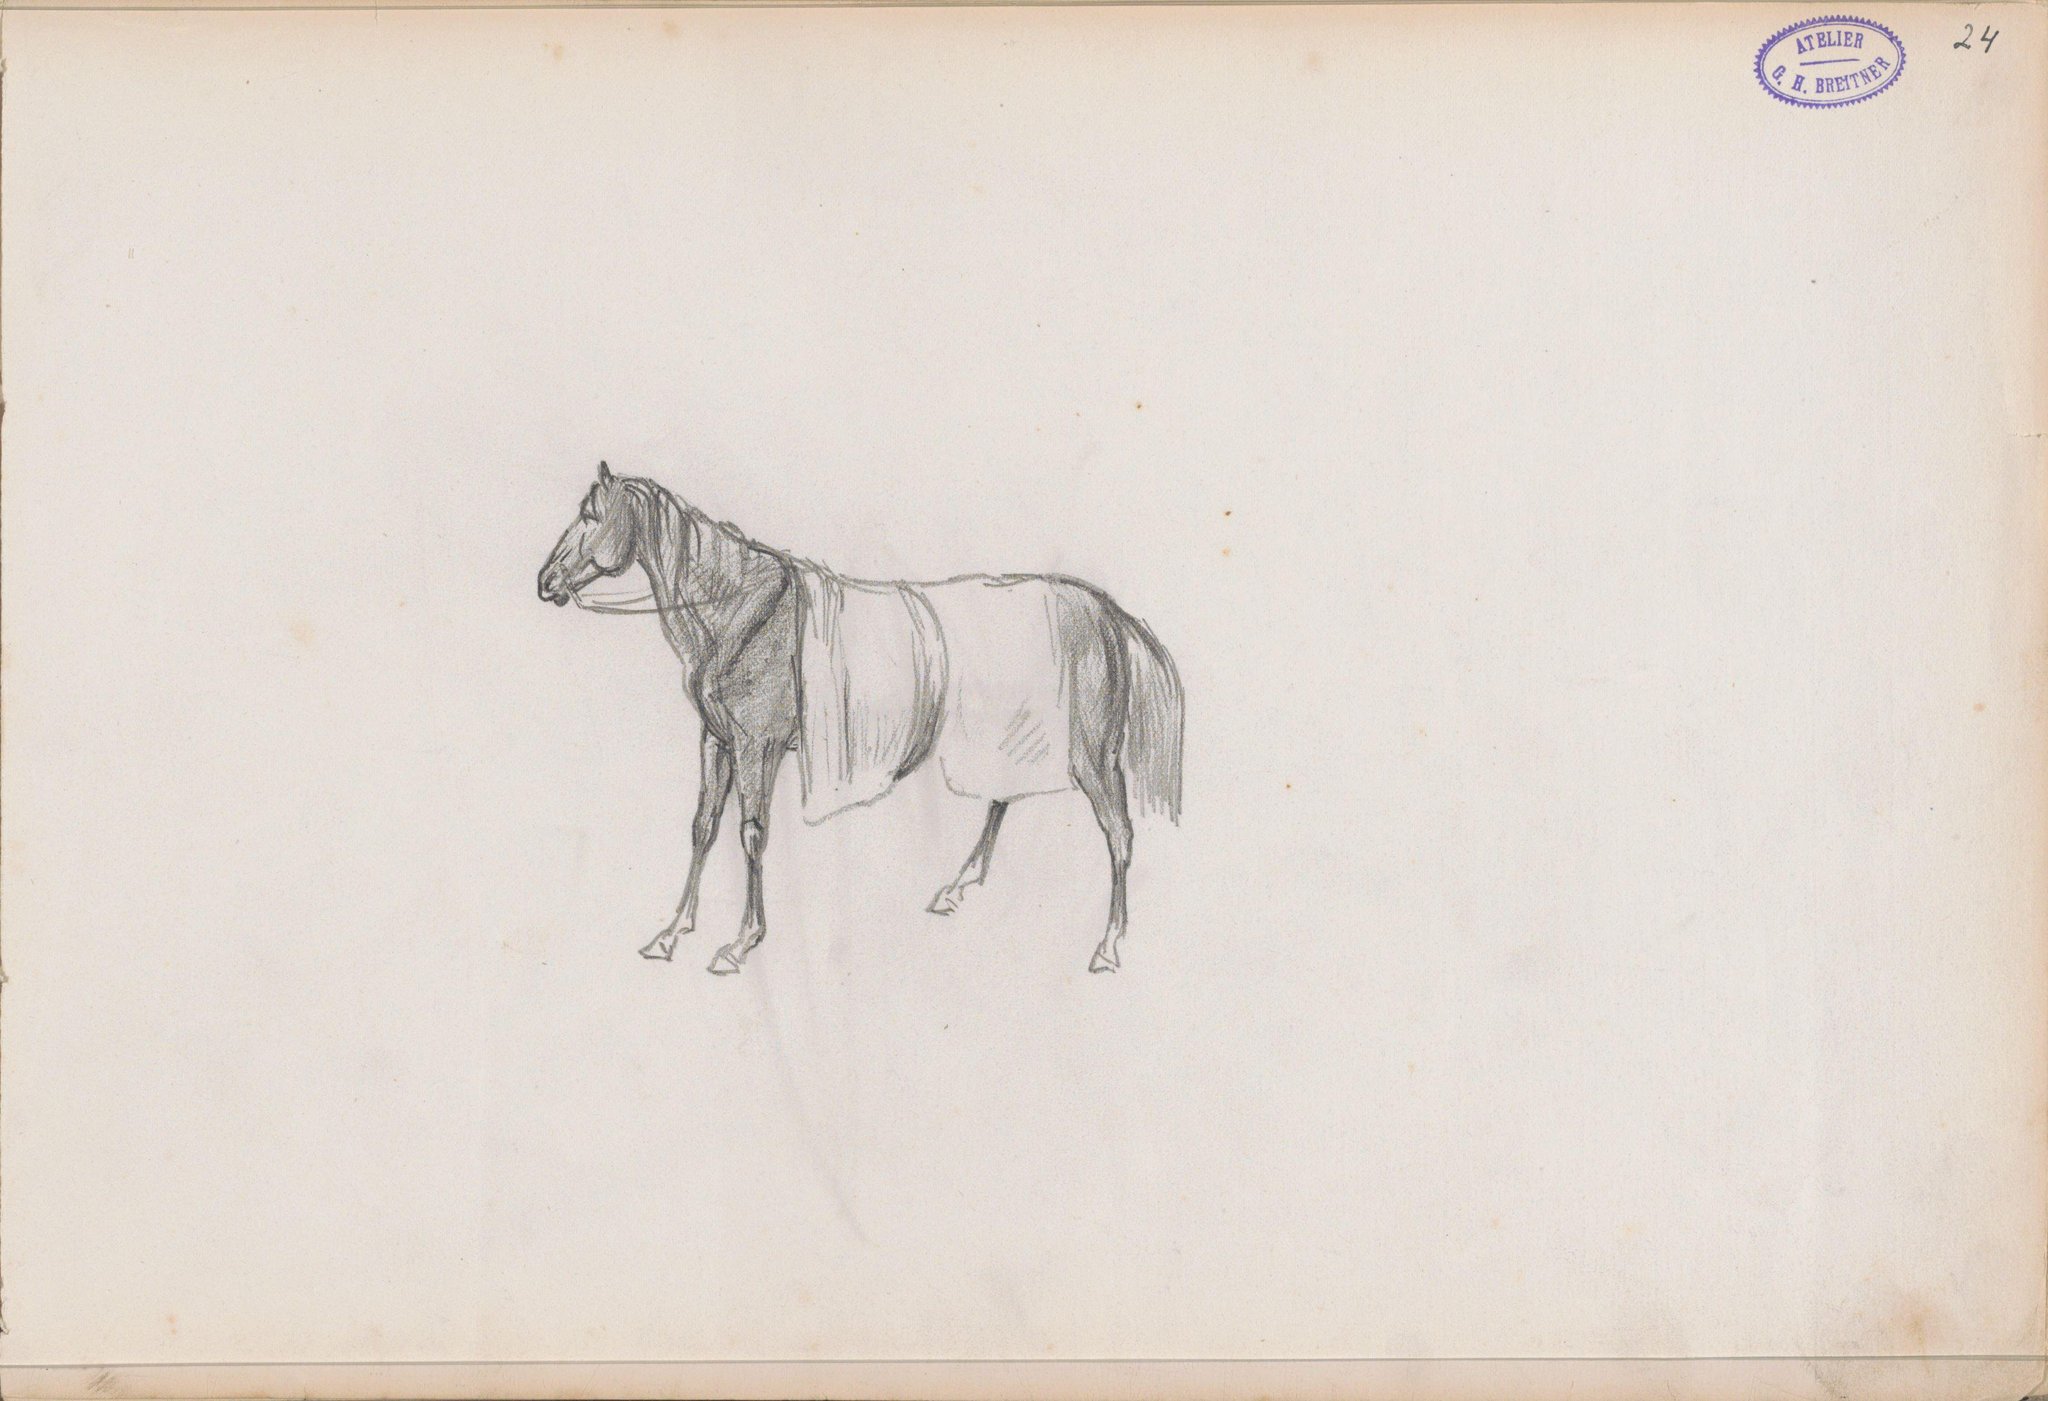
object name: sketchbook leaf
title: Paard met een deken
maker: george hendrik breitner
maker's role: draughtsman, painter, print maker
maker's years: 1857-1923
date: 1809-1872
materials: paper, pencil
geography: rotterdam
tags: horse-blanket, horse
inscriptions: workshop stamp: Lugt 291d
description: Blad 24 uit een schetsboek met 32 bladen.